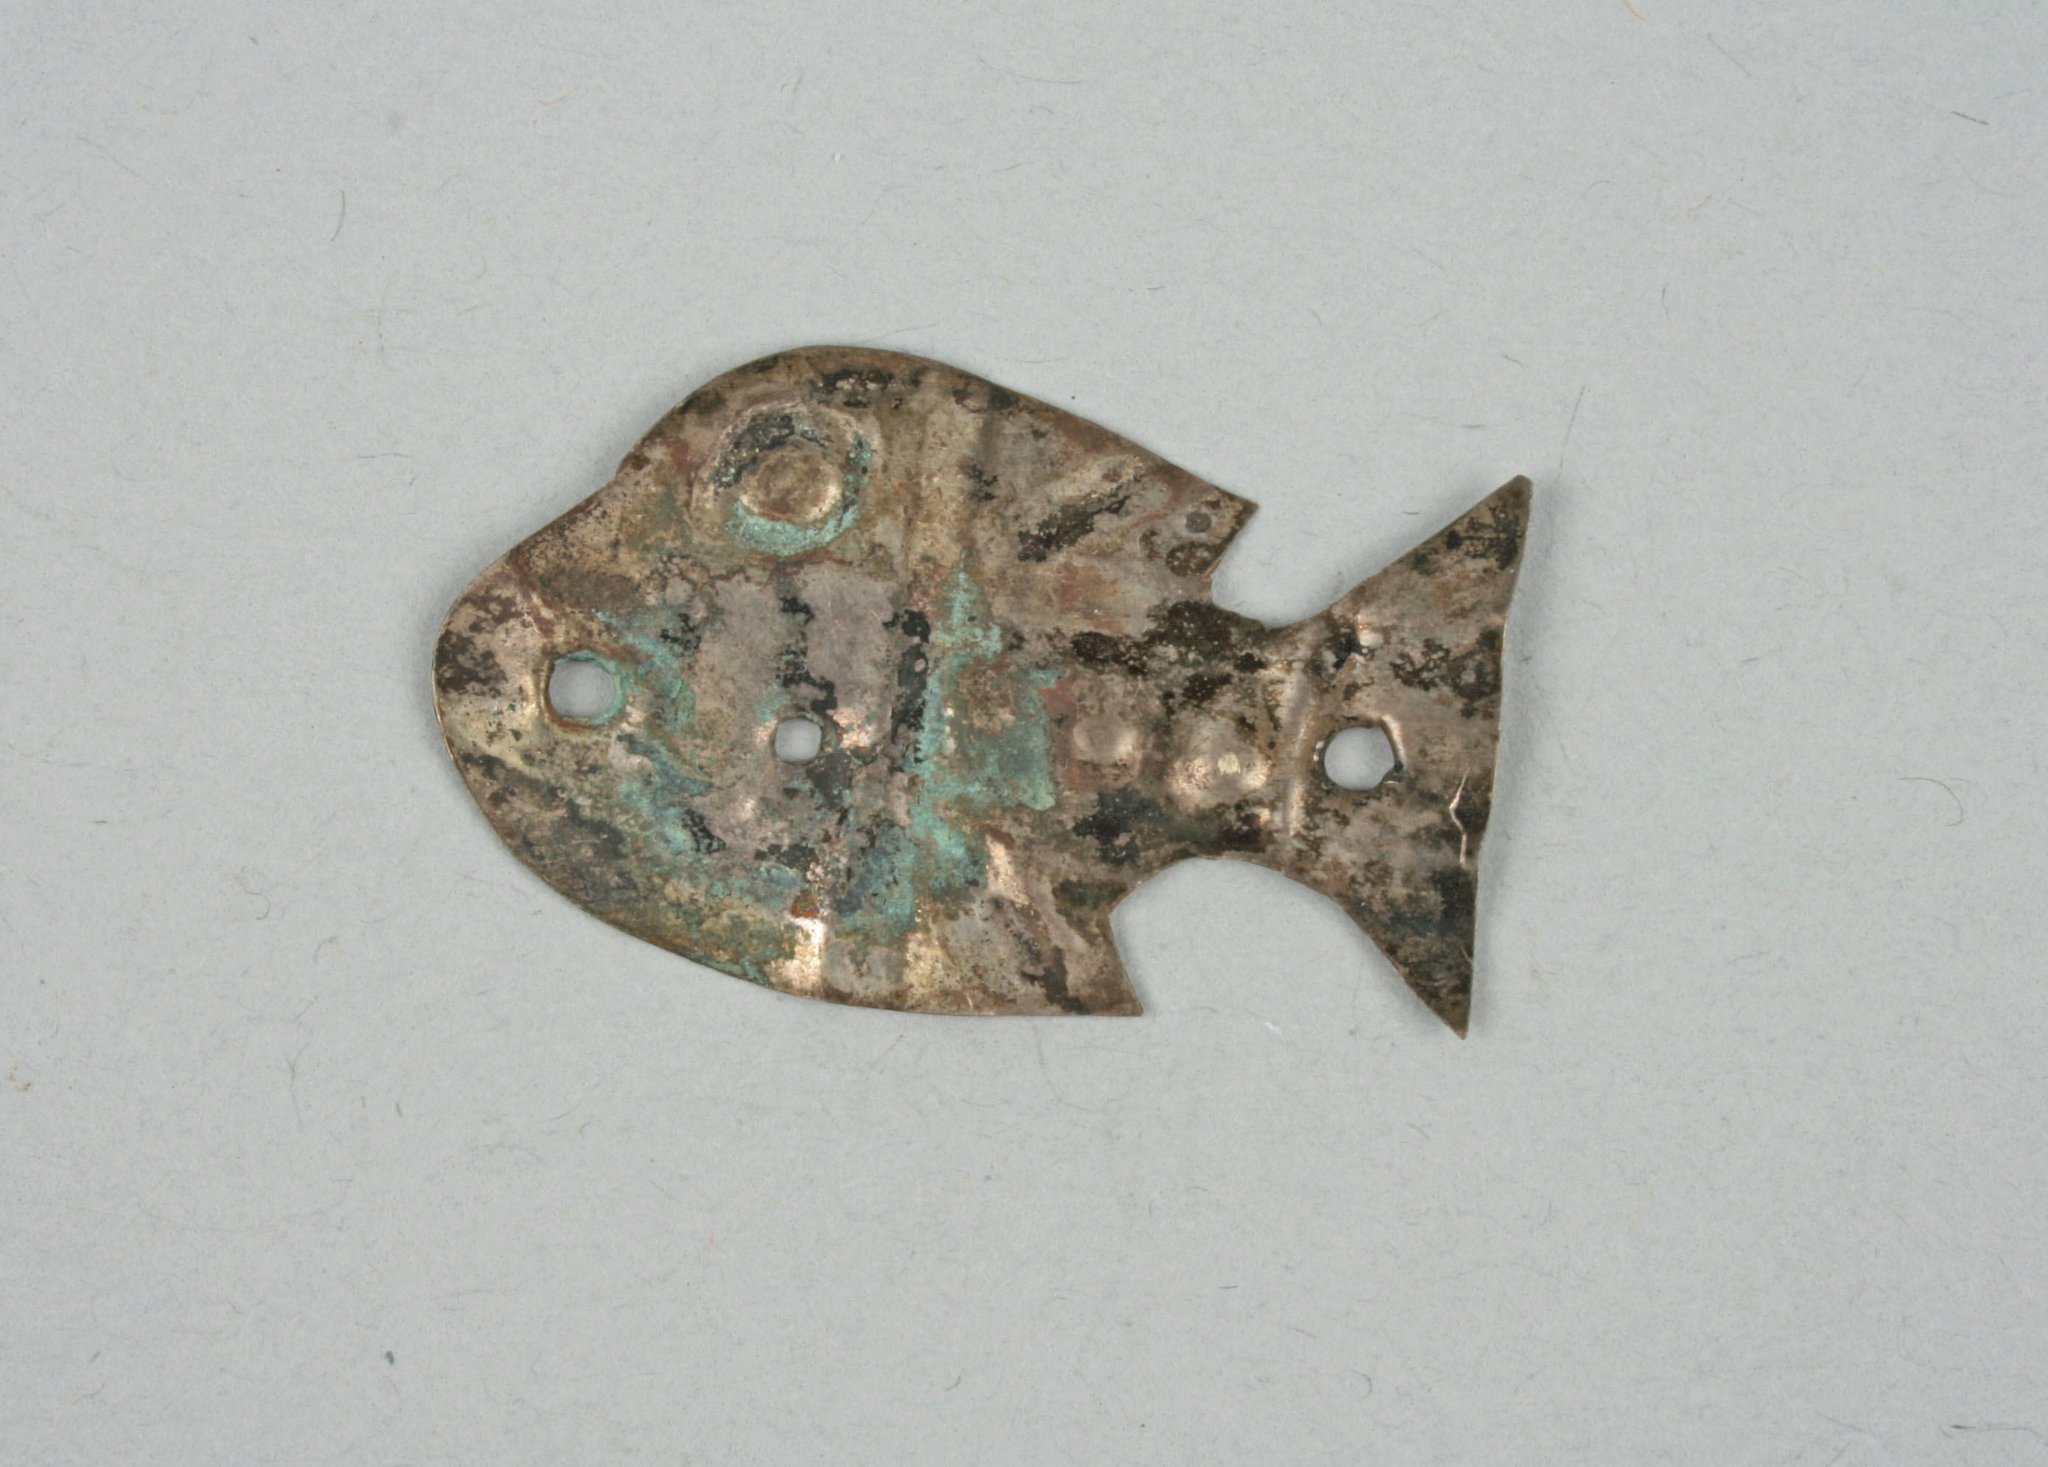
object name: ornament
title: Fish Ornament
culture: peruvian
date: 1001-1200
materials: silver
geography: peru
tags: fish